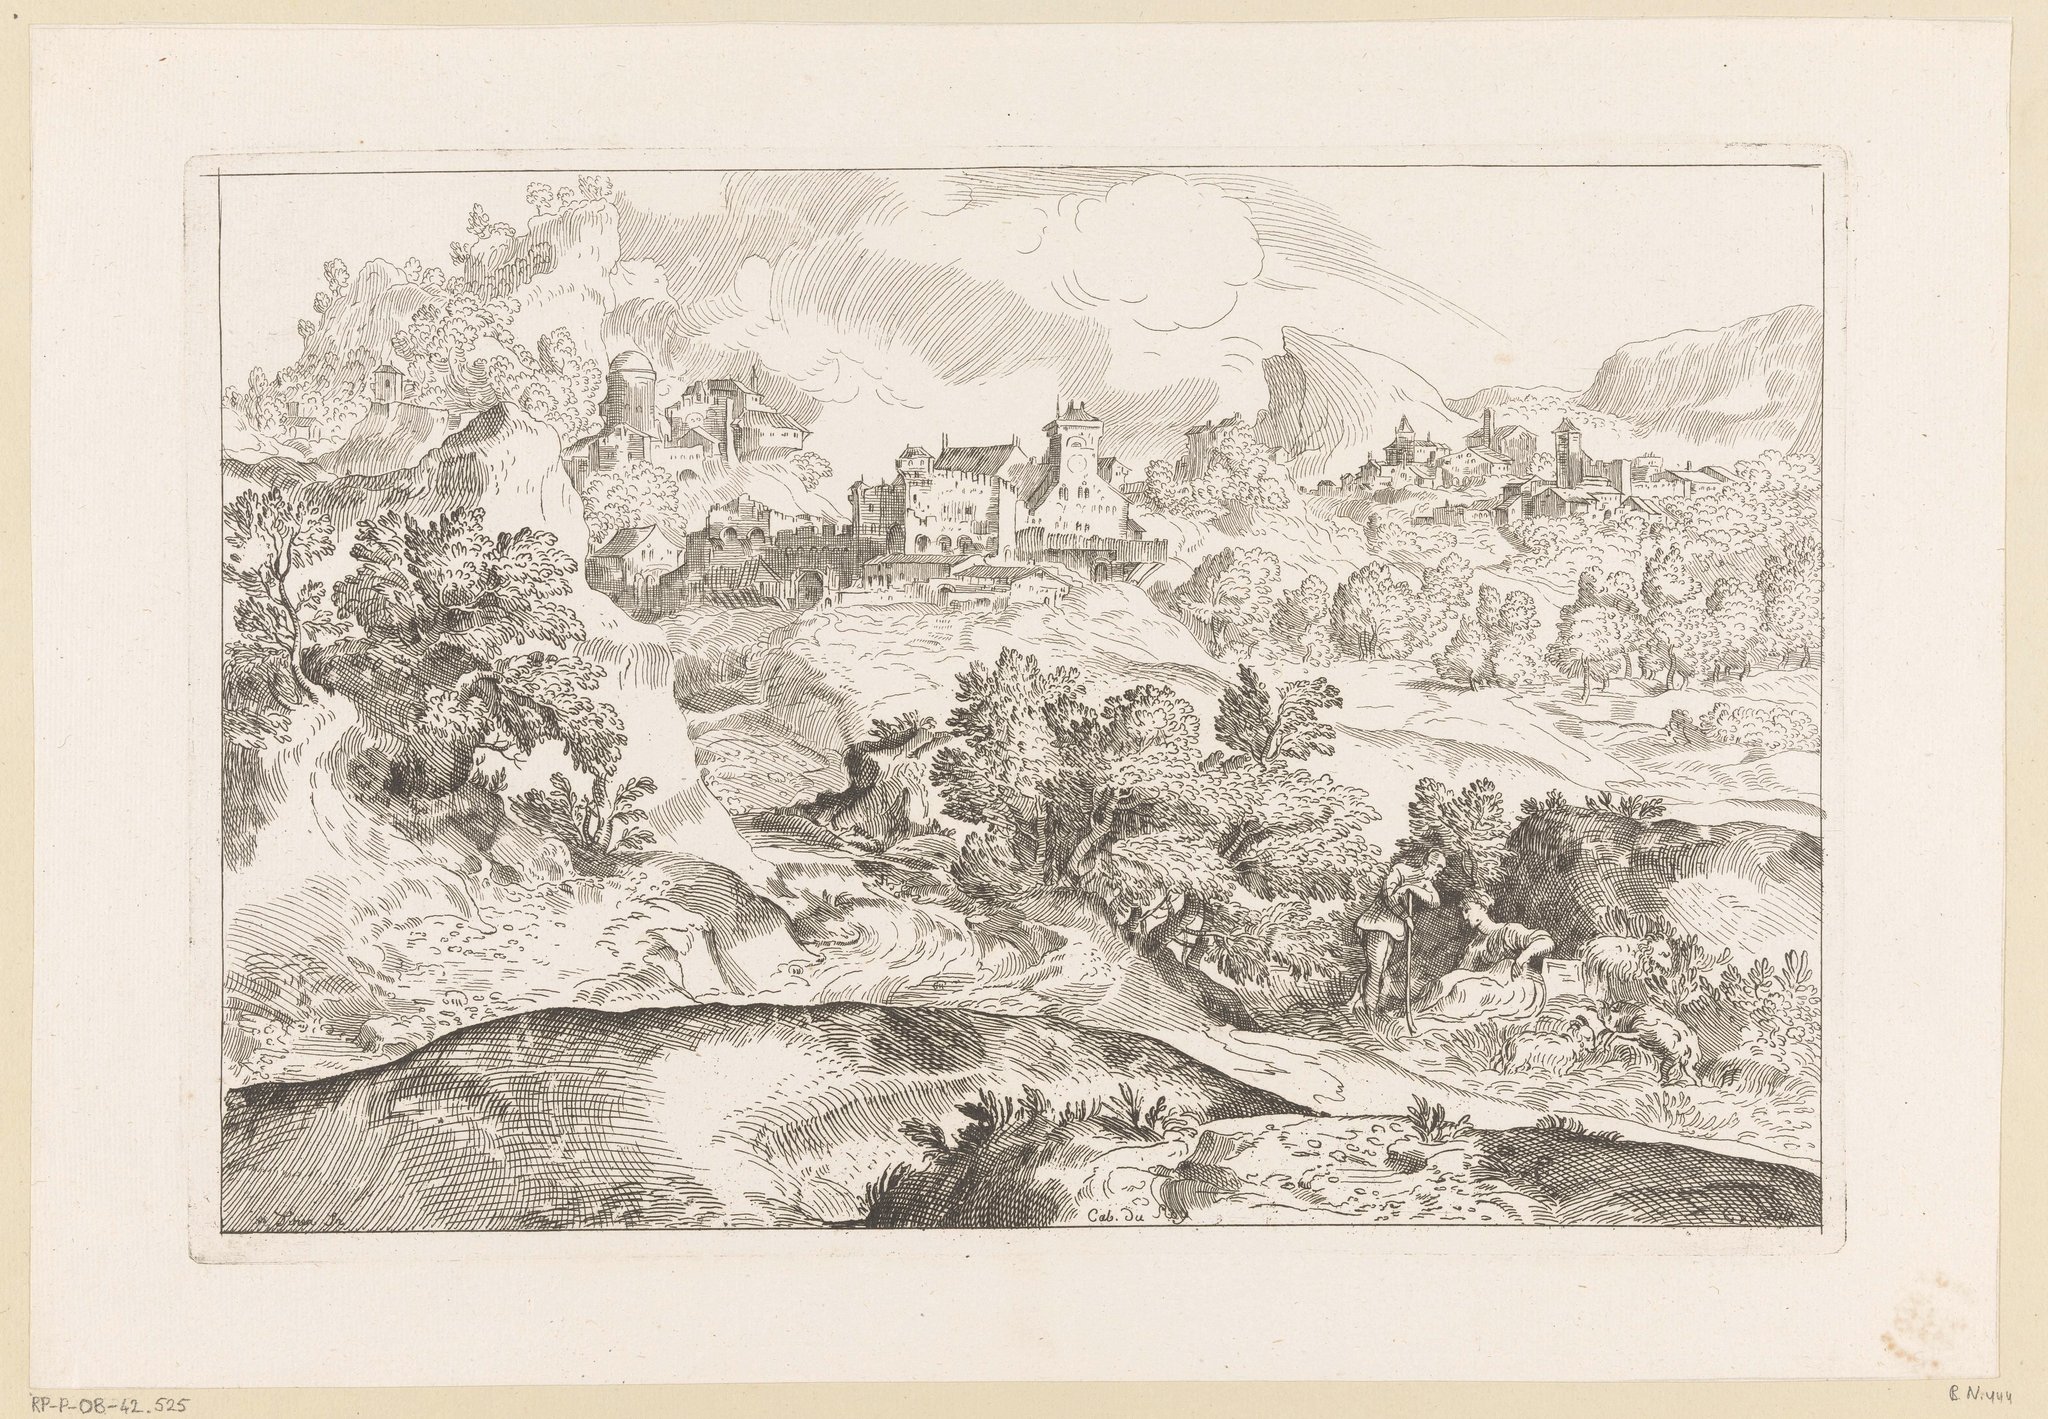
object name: print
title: Berglandschap met herders en op de achtergrond twee dorpen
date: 1702-1765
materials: paper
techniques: etching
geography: france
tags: prospect of village, silhouette of village, herding, herdsman, herdswoman, shepherd, shepherdess, cowherd, etc., mountains - hh - ideal landscapes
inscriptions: collector's mark: Lugt 240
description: Maakt deel uit van een serie getiteld: "Cabinet du Roy" van 222 etsen naar tekeningen uit de Franse koninklijke collectie.